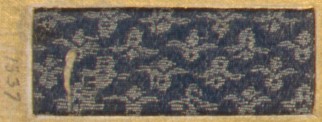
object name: piece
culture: japanese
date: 1701-1900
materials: silk